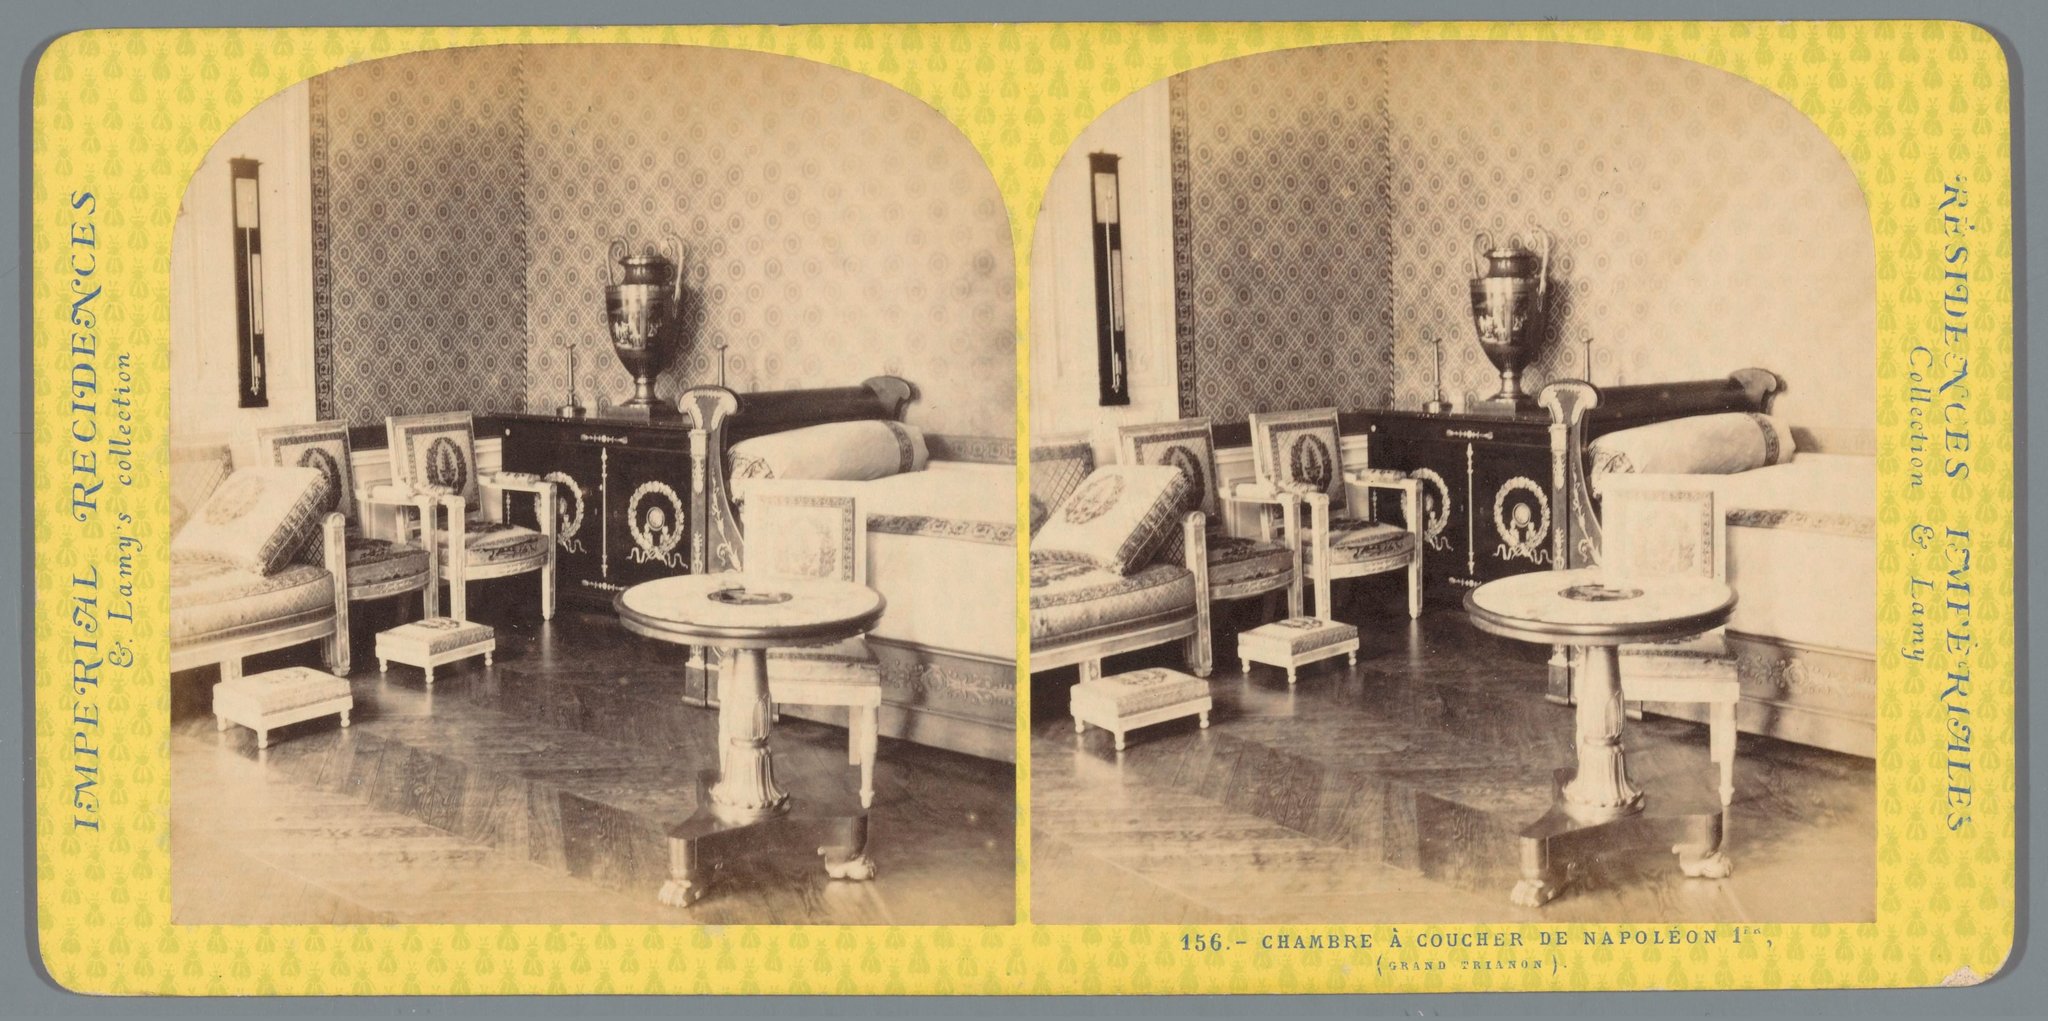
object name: stereograph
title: Chambre a Coucher de Napoleon 1er, (Grand Trianon)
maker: ernest eléonor pierre lamy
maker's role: publisher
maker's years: 1828-1900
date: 1860-1880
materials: cardboard, photographic support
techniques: albumen print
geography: grand trianon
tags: bedroom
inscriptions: number: ‘156.’, inscription: ‘E. Lamy's collection’